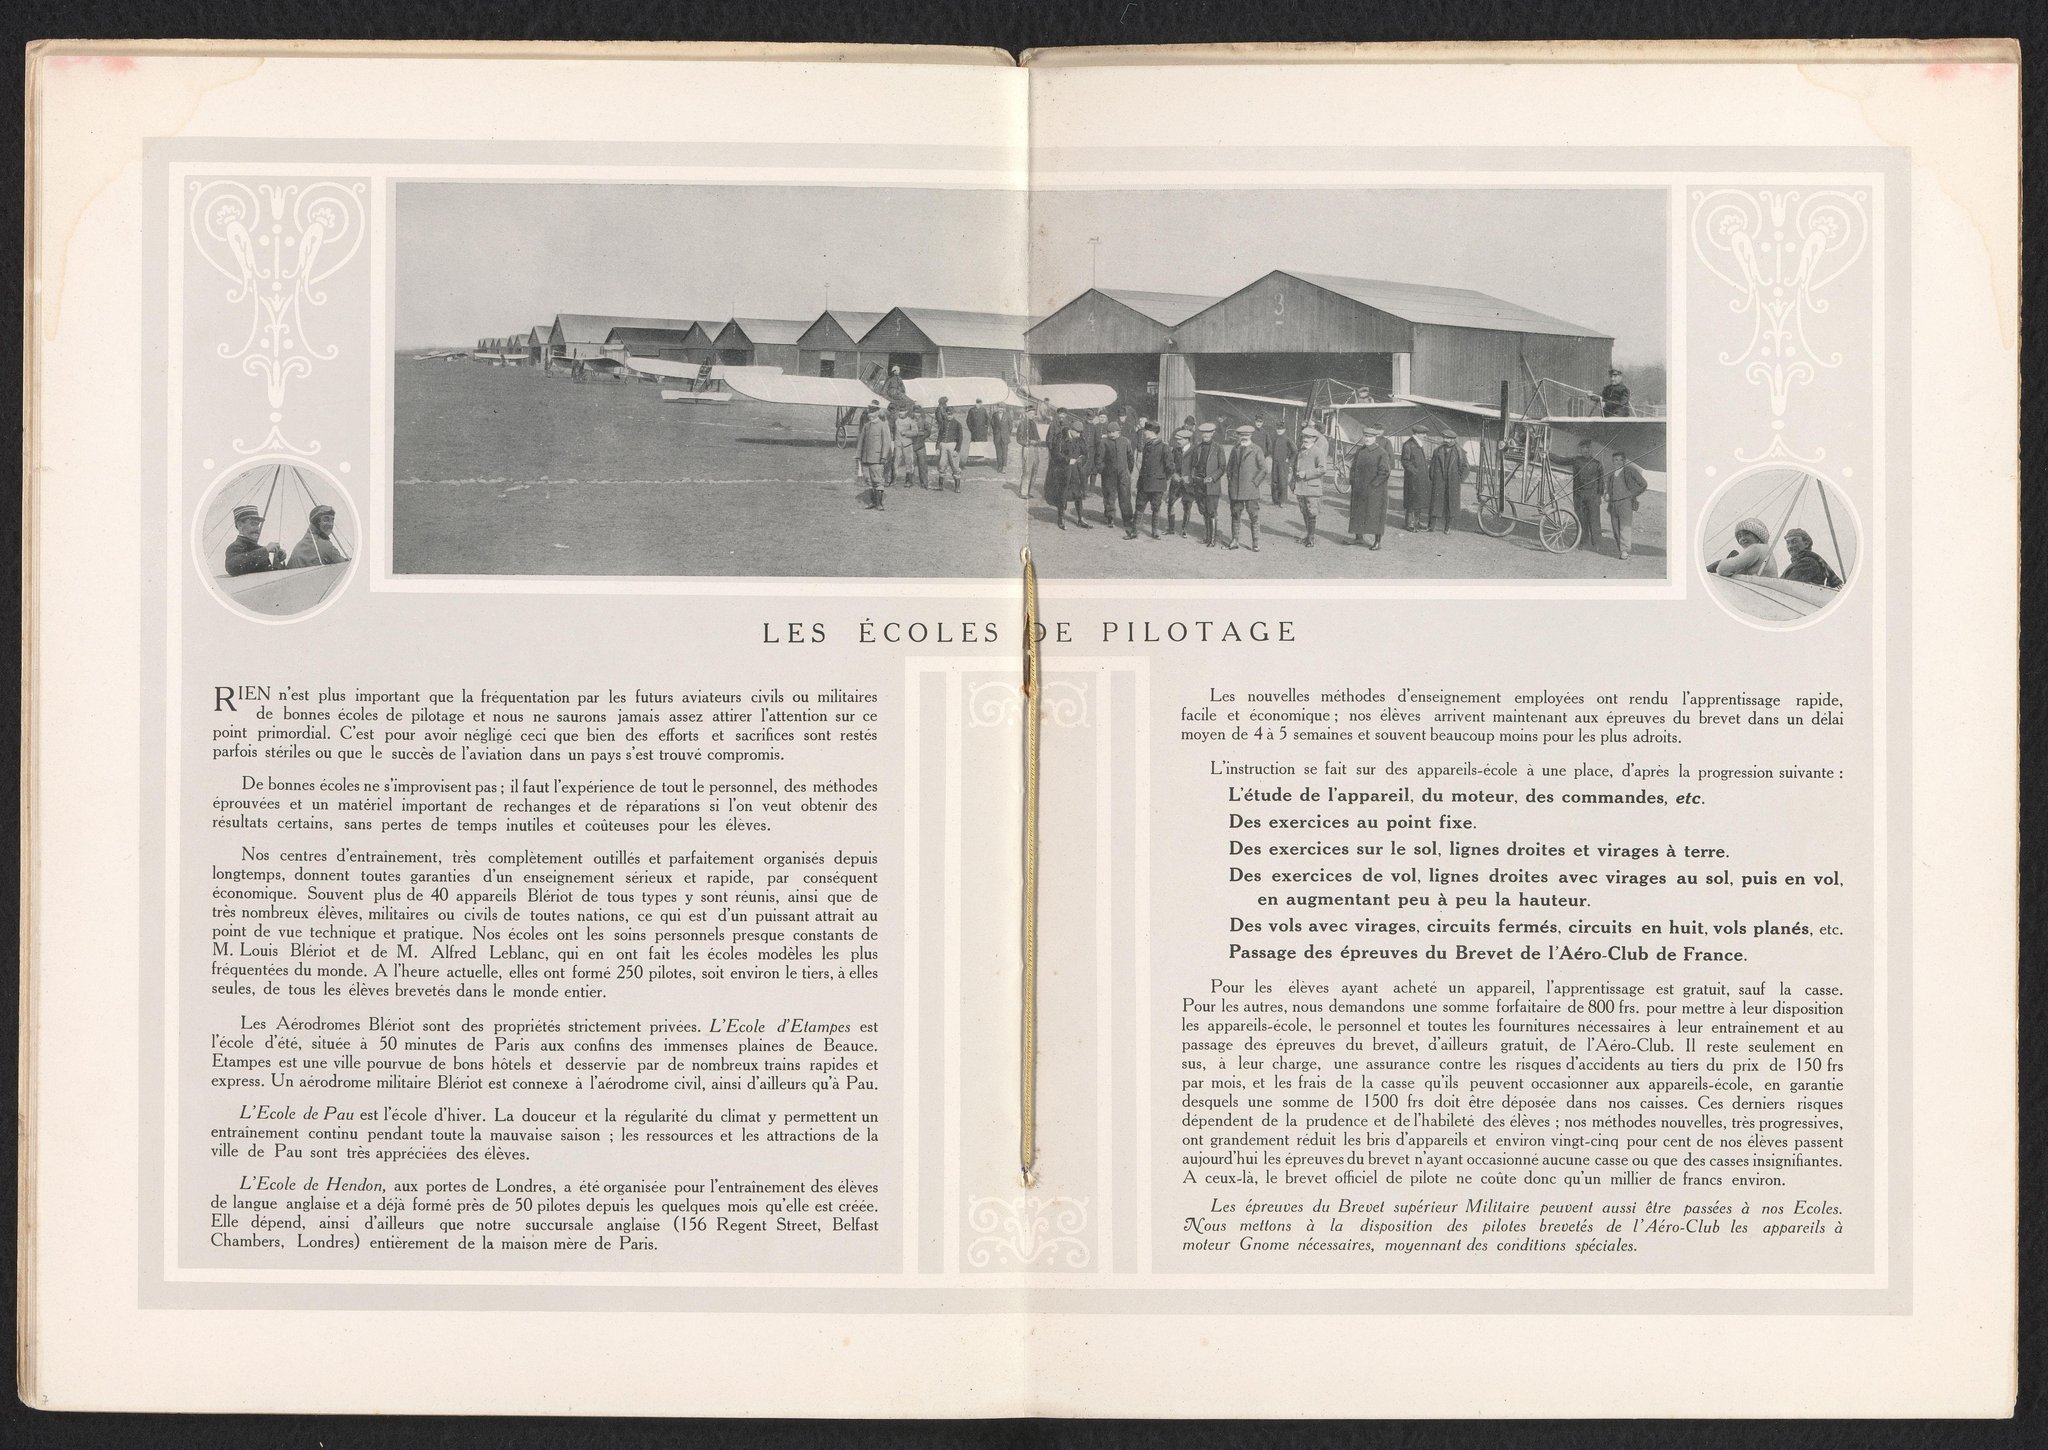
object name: page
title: Gezicht op hangar van vliegschool met bemanning en vliegeniers, aan weerszijden bemanning gezien vanaf een vliegtuig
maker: Anonymous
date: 1907-1912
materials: paper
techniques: letterpress printing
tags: aircraft, aeroplane, flight crew, hangar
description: Prenten op achtste en negende ongenummerde pagina.